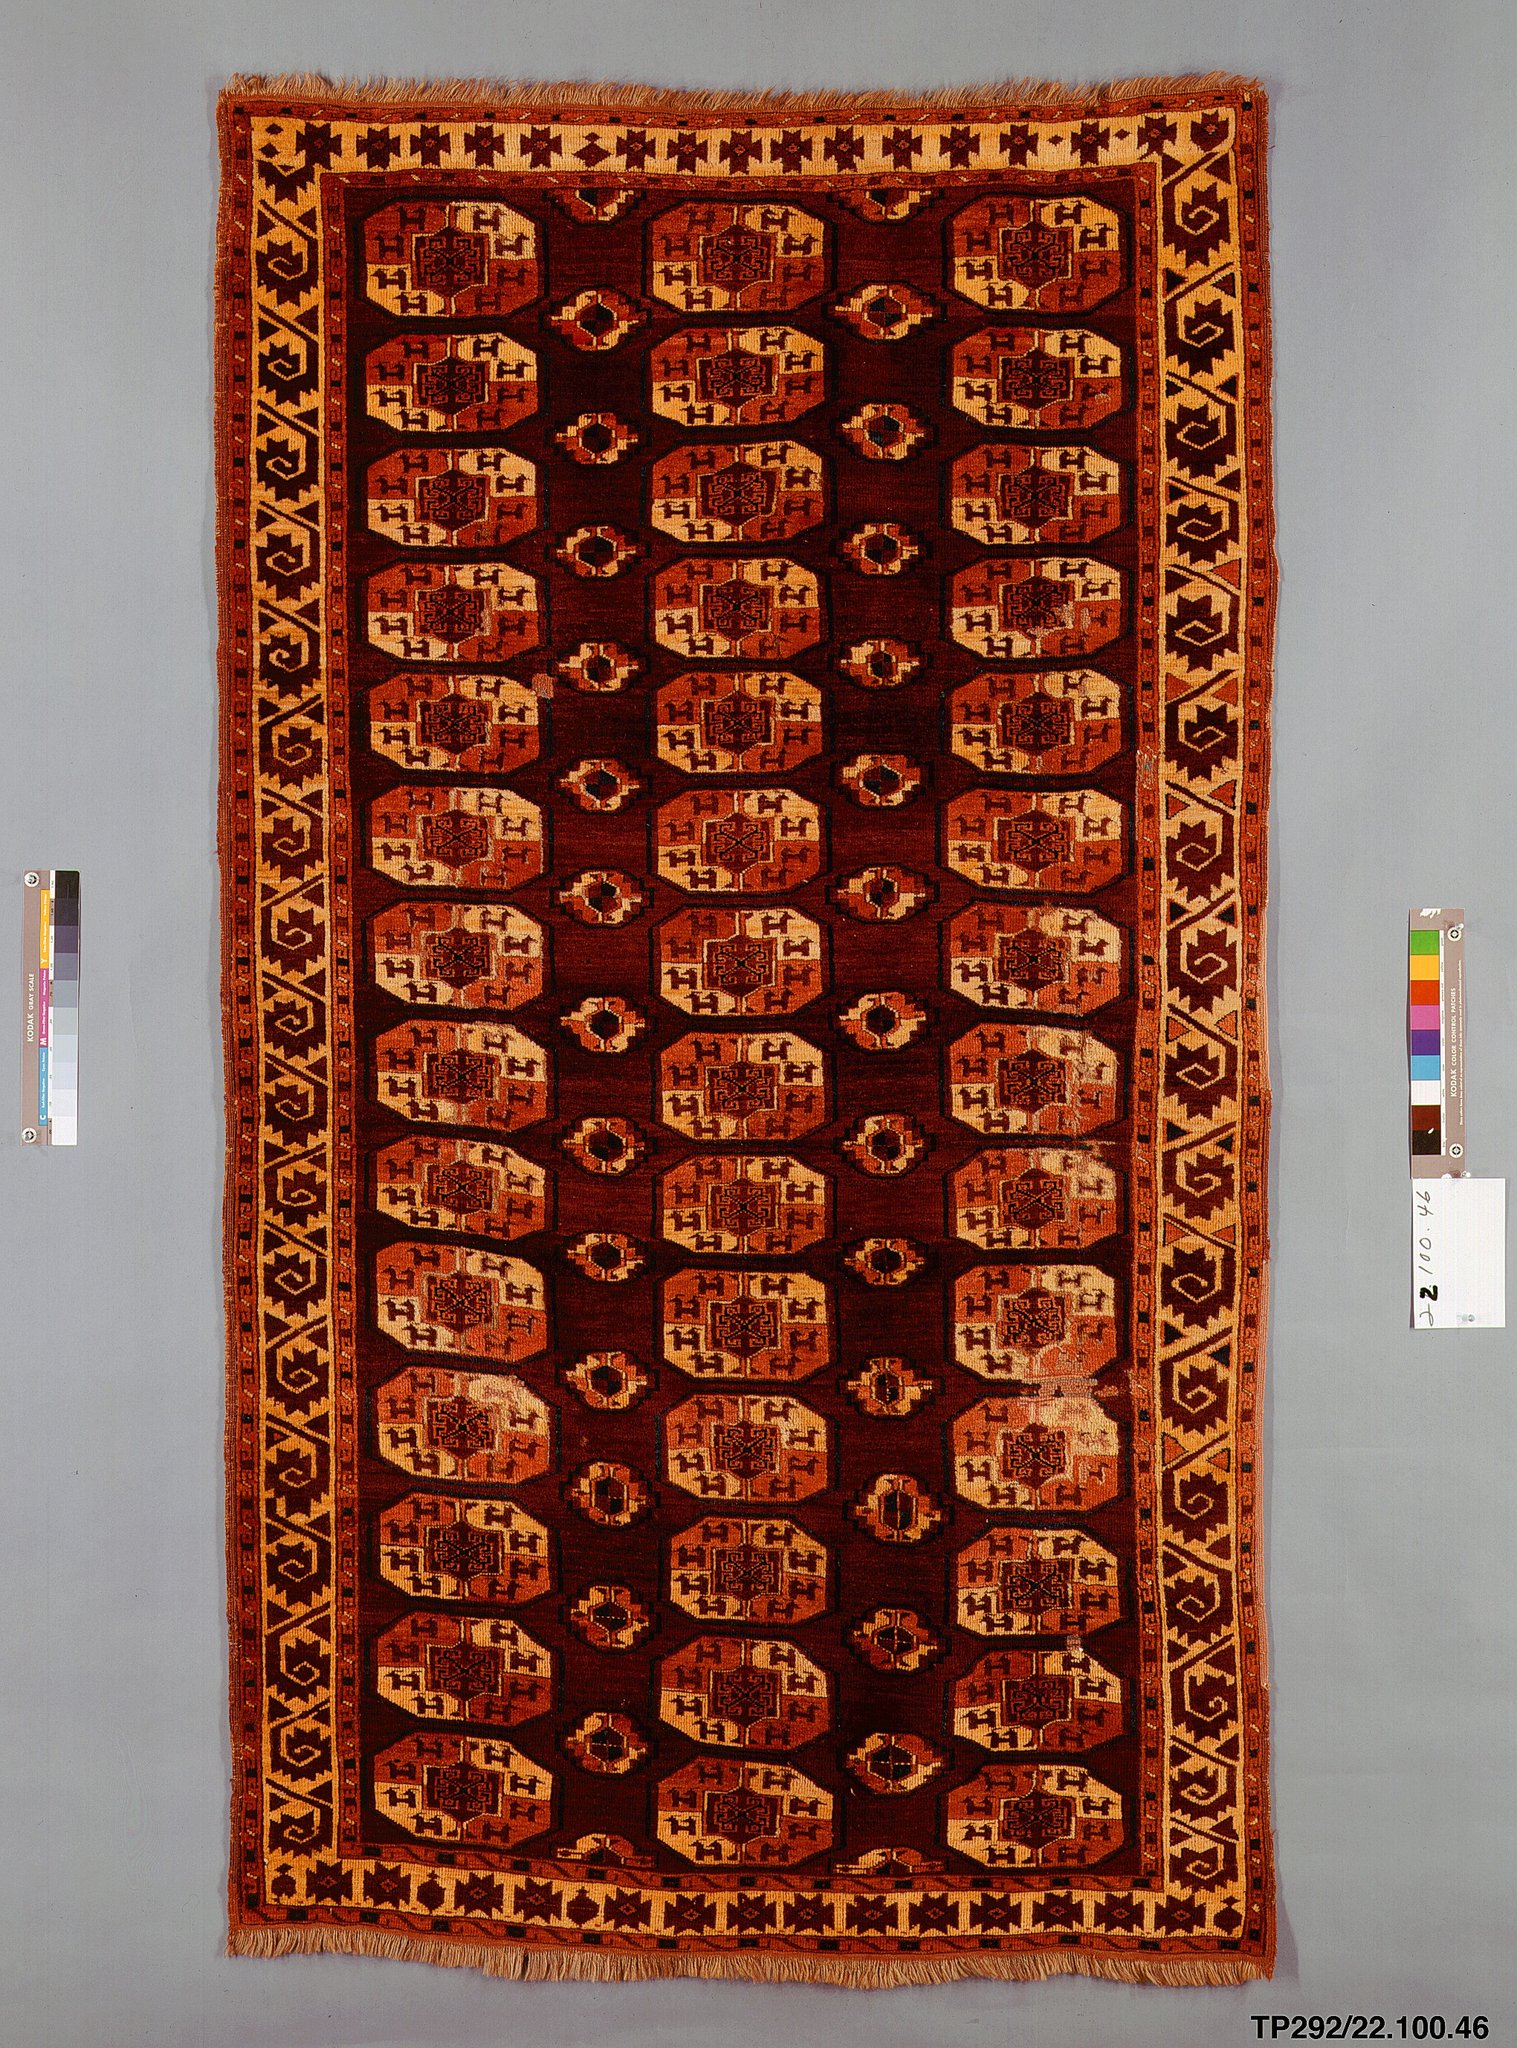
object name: carpet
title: Yamut Carpet with Octagonal Guls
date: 1801-1833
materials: wool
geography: western turkmenistan